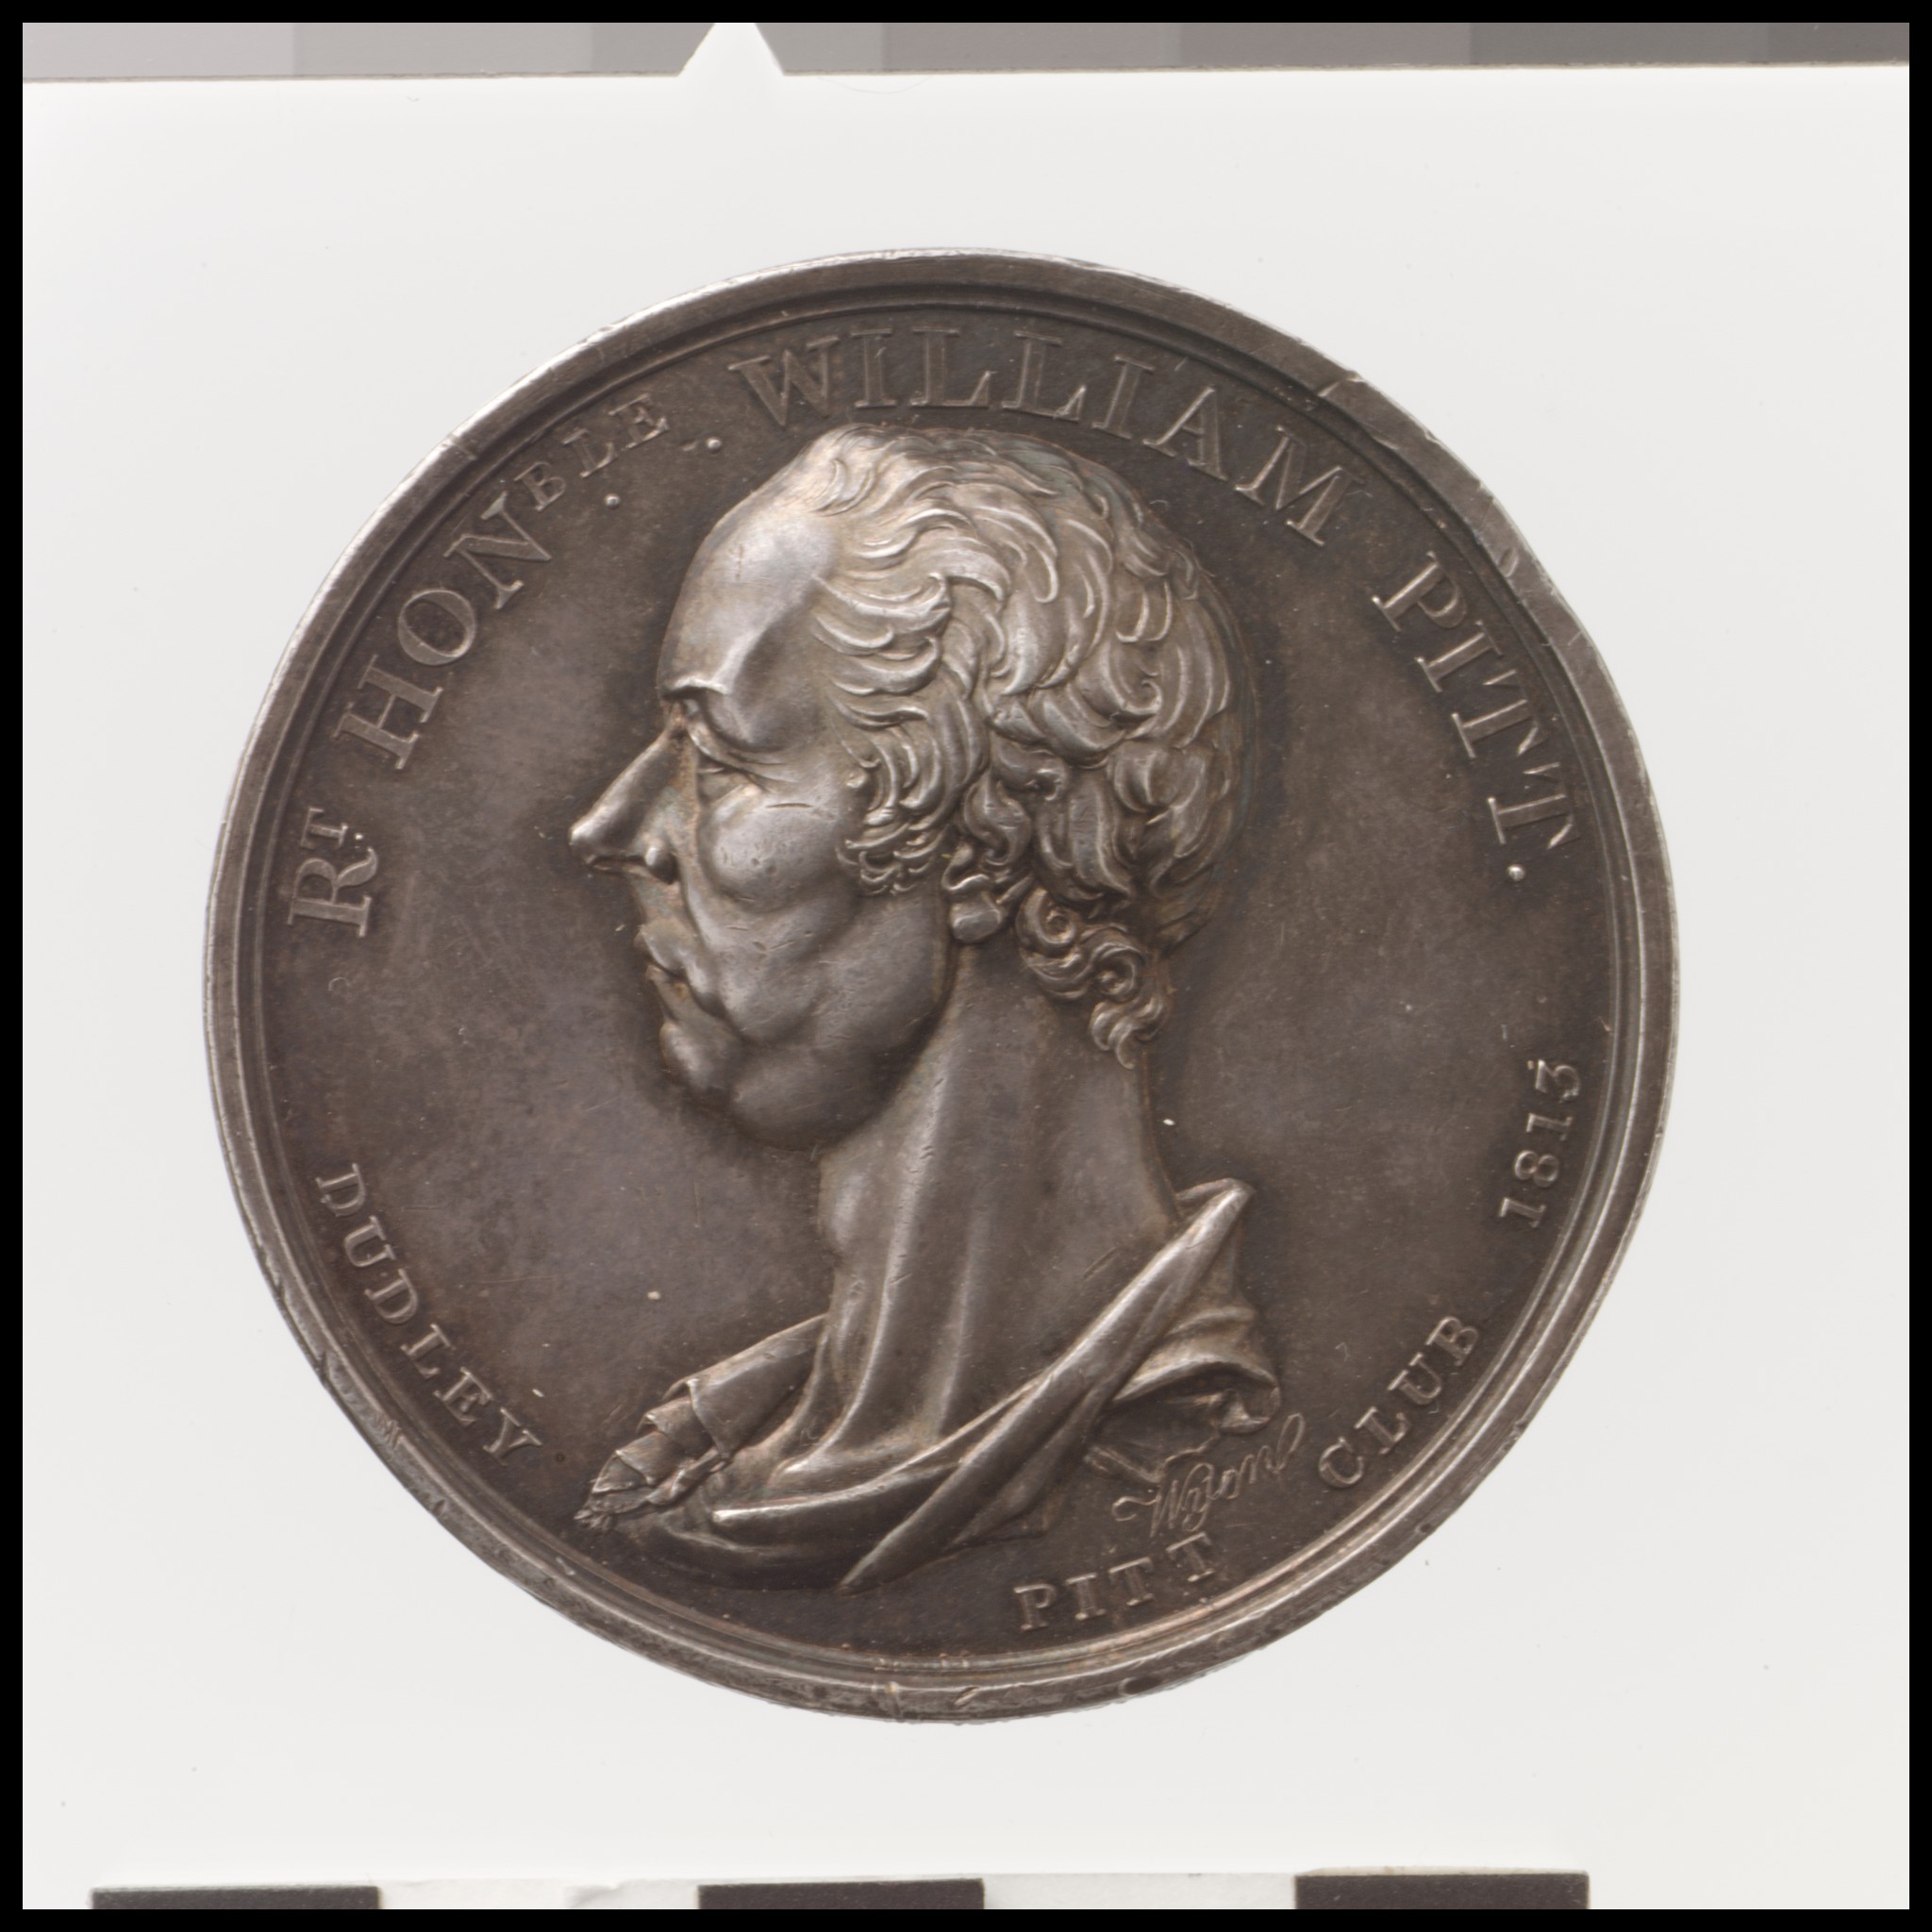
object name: medal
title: William Pitt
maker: thomas wyon the younger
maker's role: artist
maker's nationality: british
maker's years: 1791-1817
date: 1813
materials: silver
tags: men,profiles